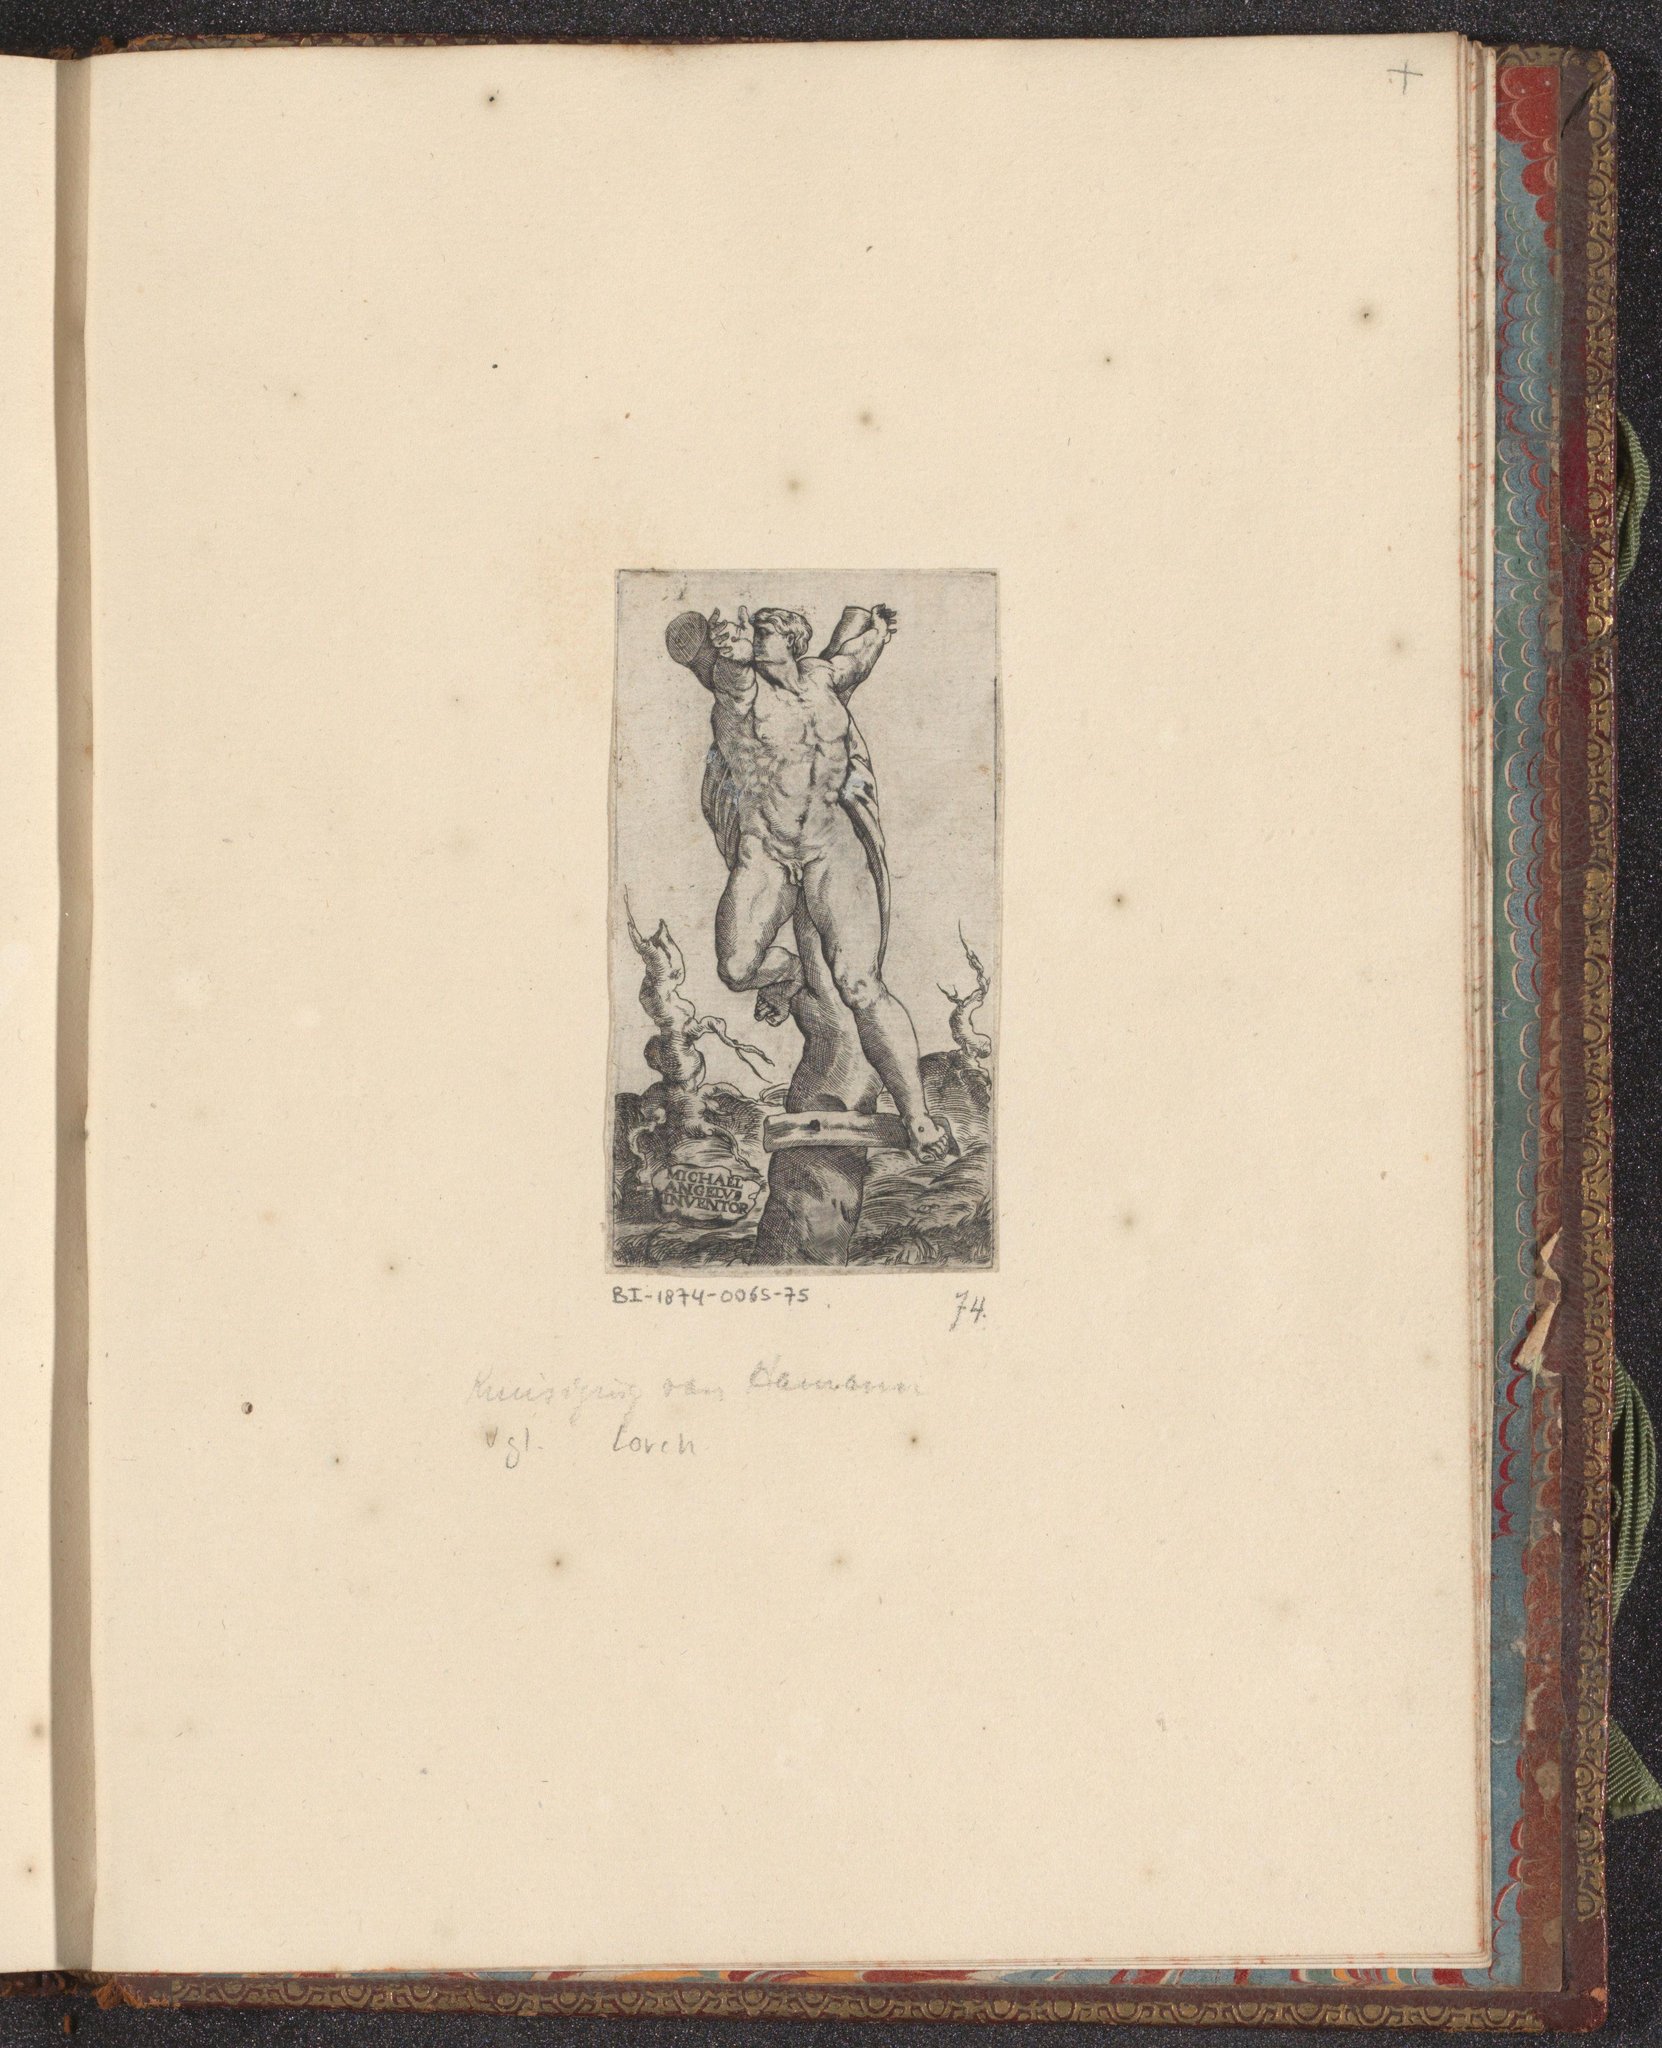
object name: print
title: Straf van Haman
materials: paper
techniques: engraving, intaglio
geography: vatican city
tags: haman on the gallows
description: De naakte Haman vastgenageld aan een boomstam. De prent maakt deel uit van een album.